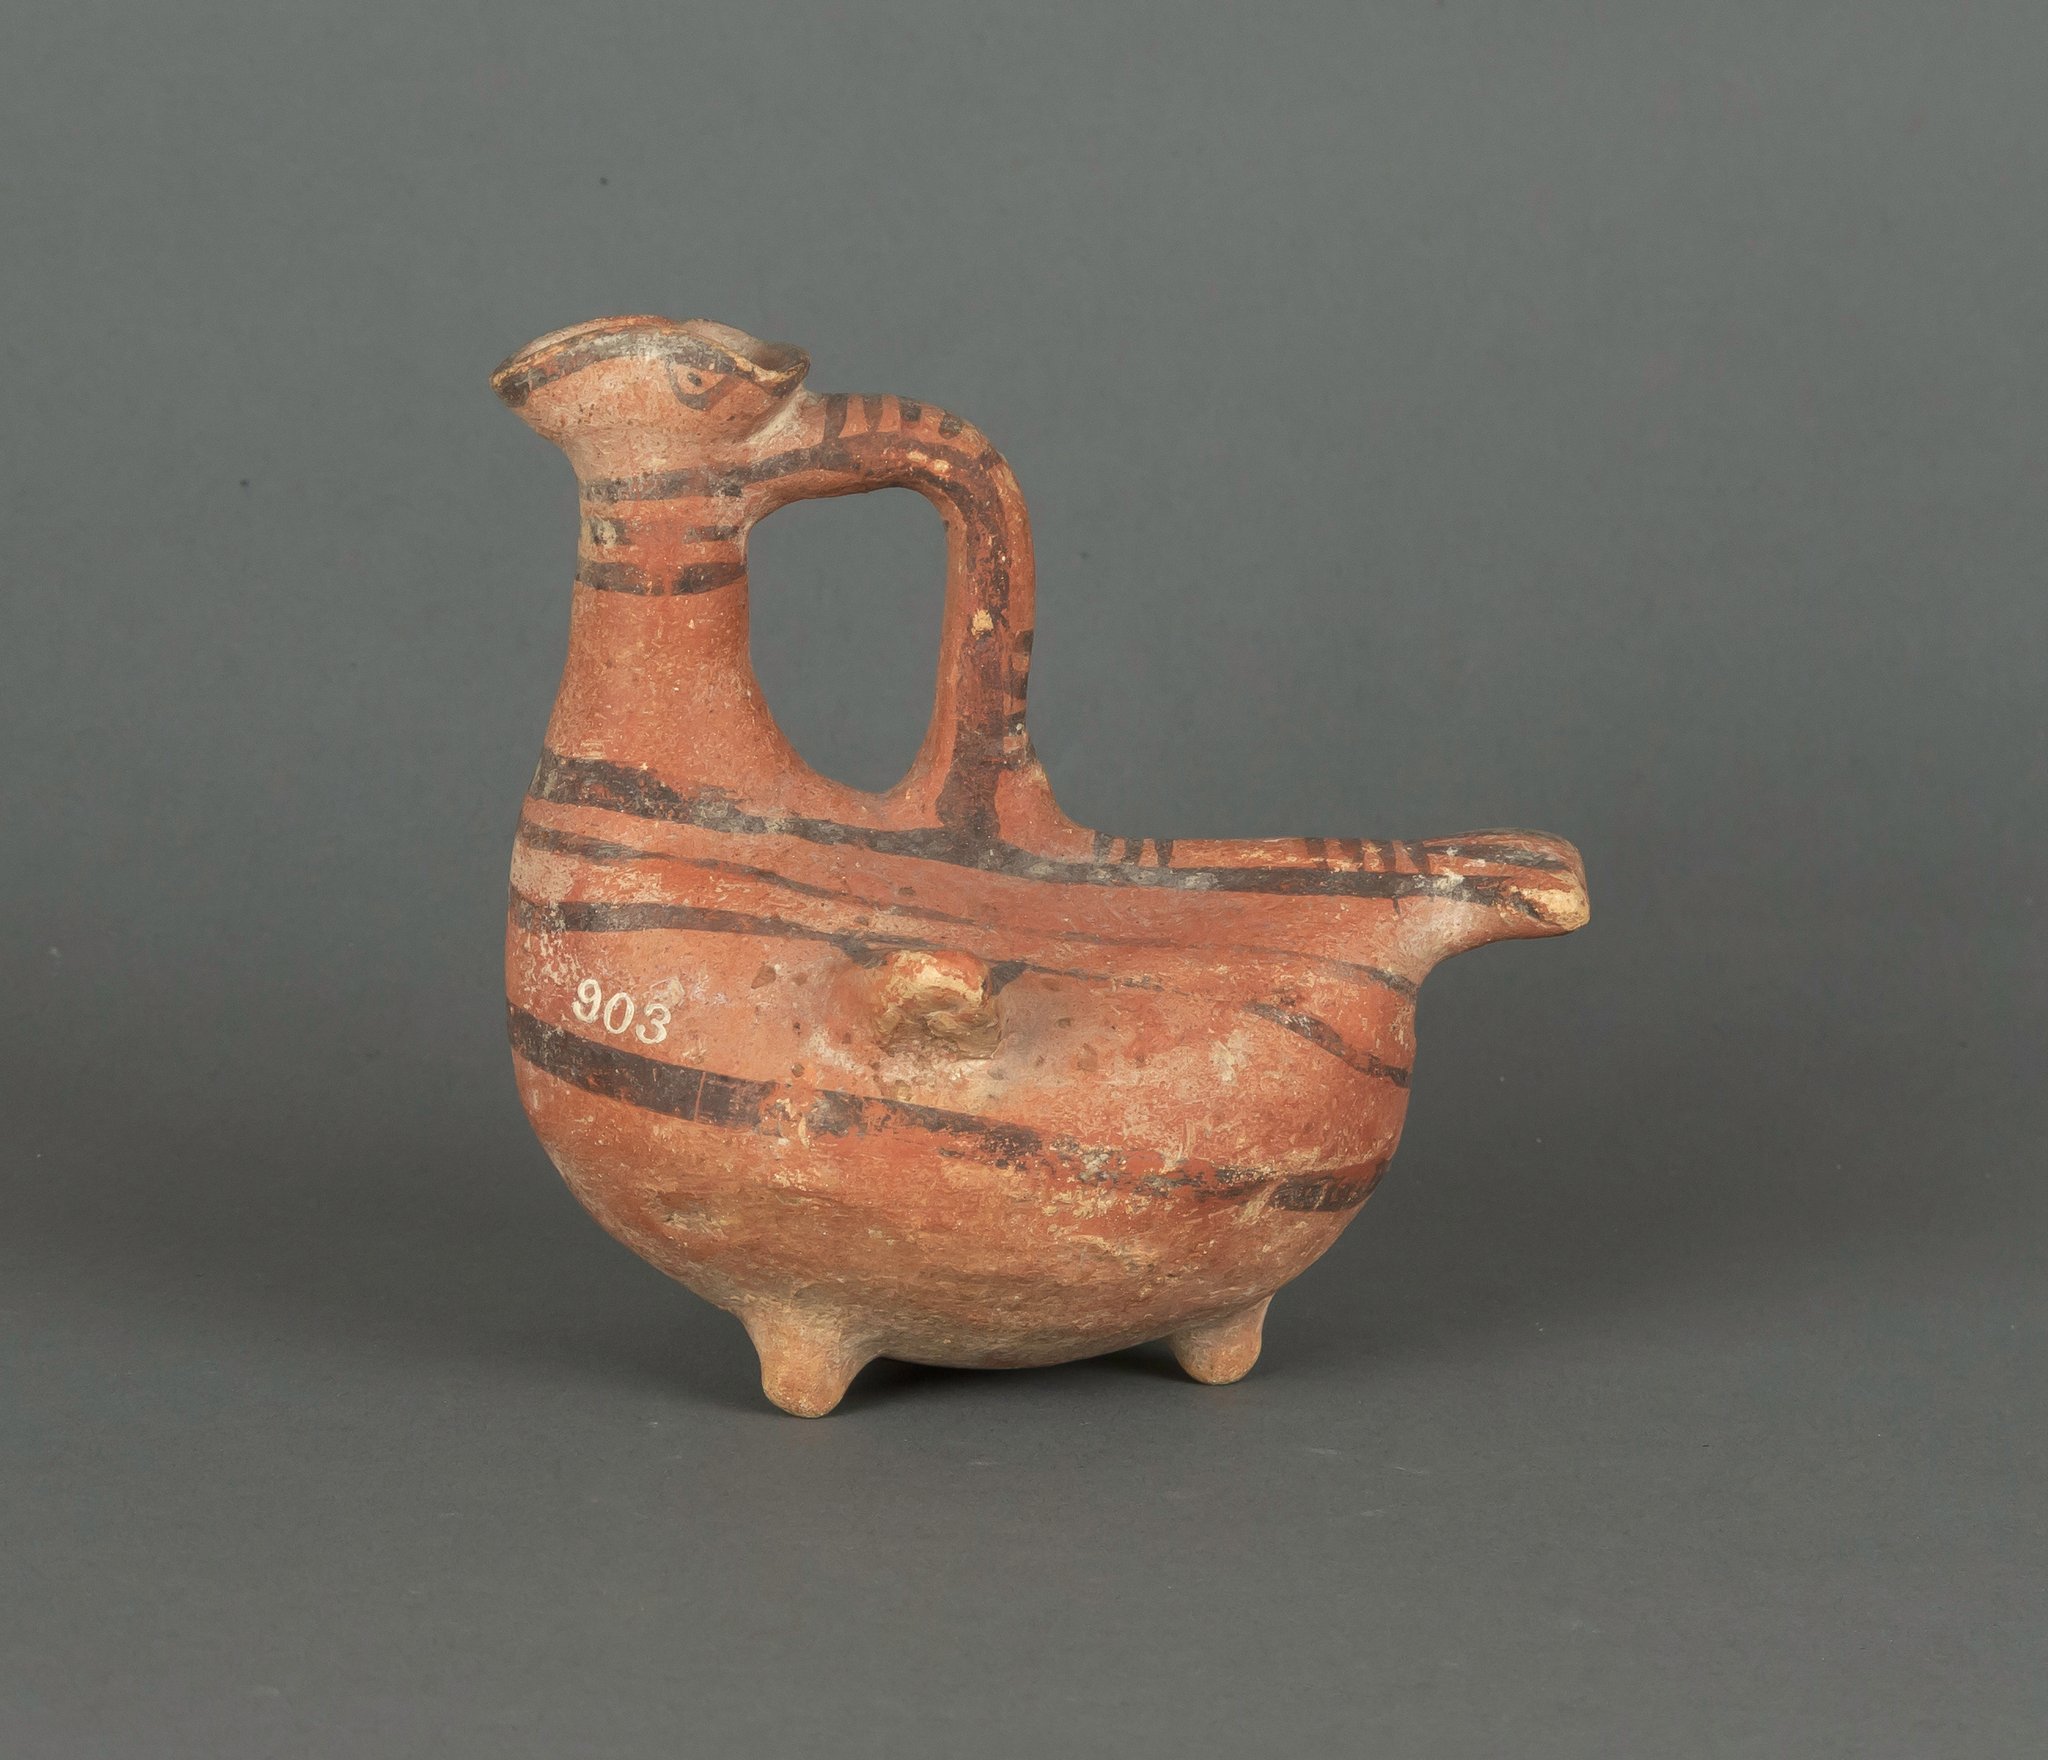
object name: askos in the form of a bird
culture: cypriot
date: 750-480 BCE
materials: terracotta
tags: birds